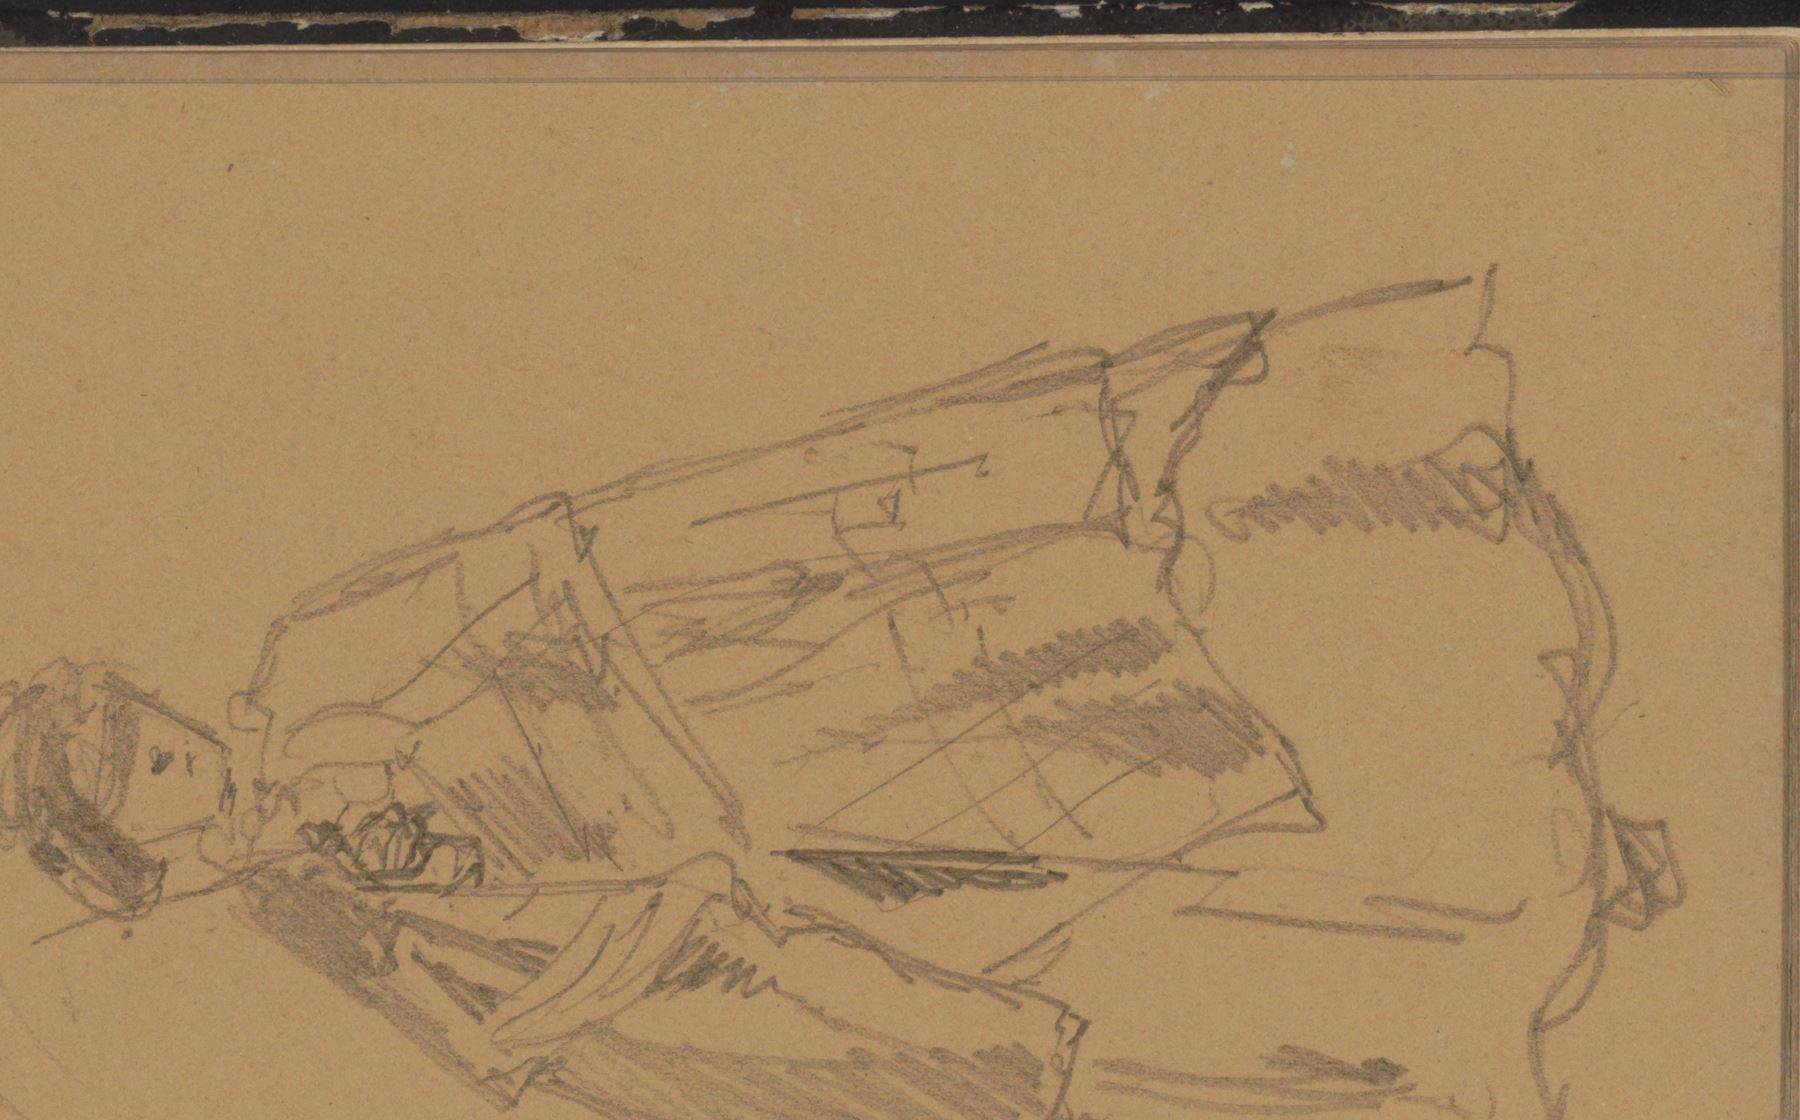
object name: sketchbook leaf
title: Vrouw met een parasol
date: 1863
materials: paper, pencil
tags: adult woman, clothes, costume (+ women's clothes), head-gear: hat (+ women's clothes), parasol, sunshade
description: Vrouw met een parasol. Ze draagt een jurk, een mantel en een hoed. Blad 43 uit een schetsboek met 55 bladen vervaardigd op de Veluwe en in Noord-Duitsland.